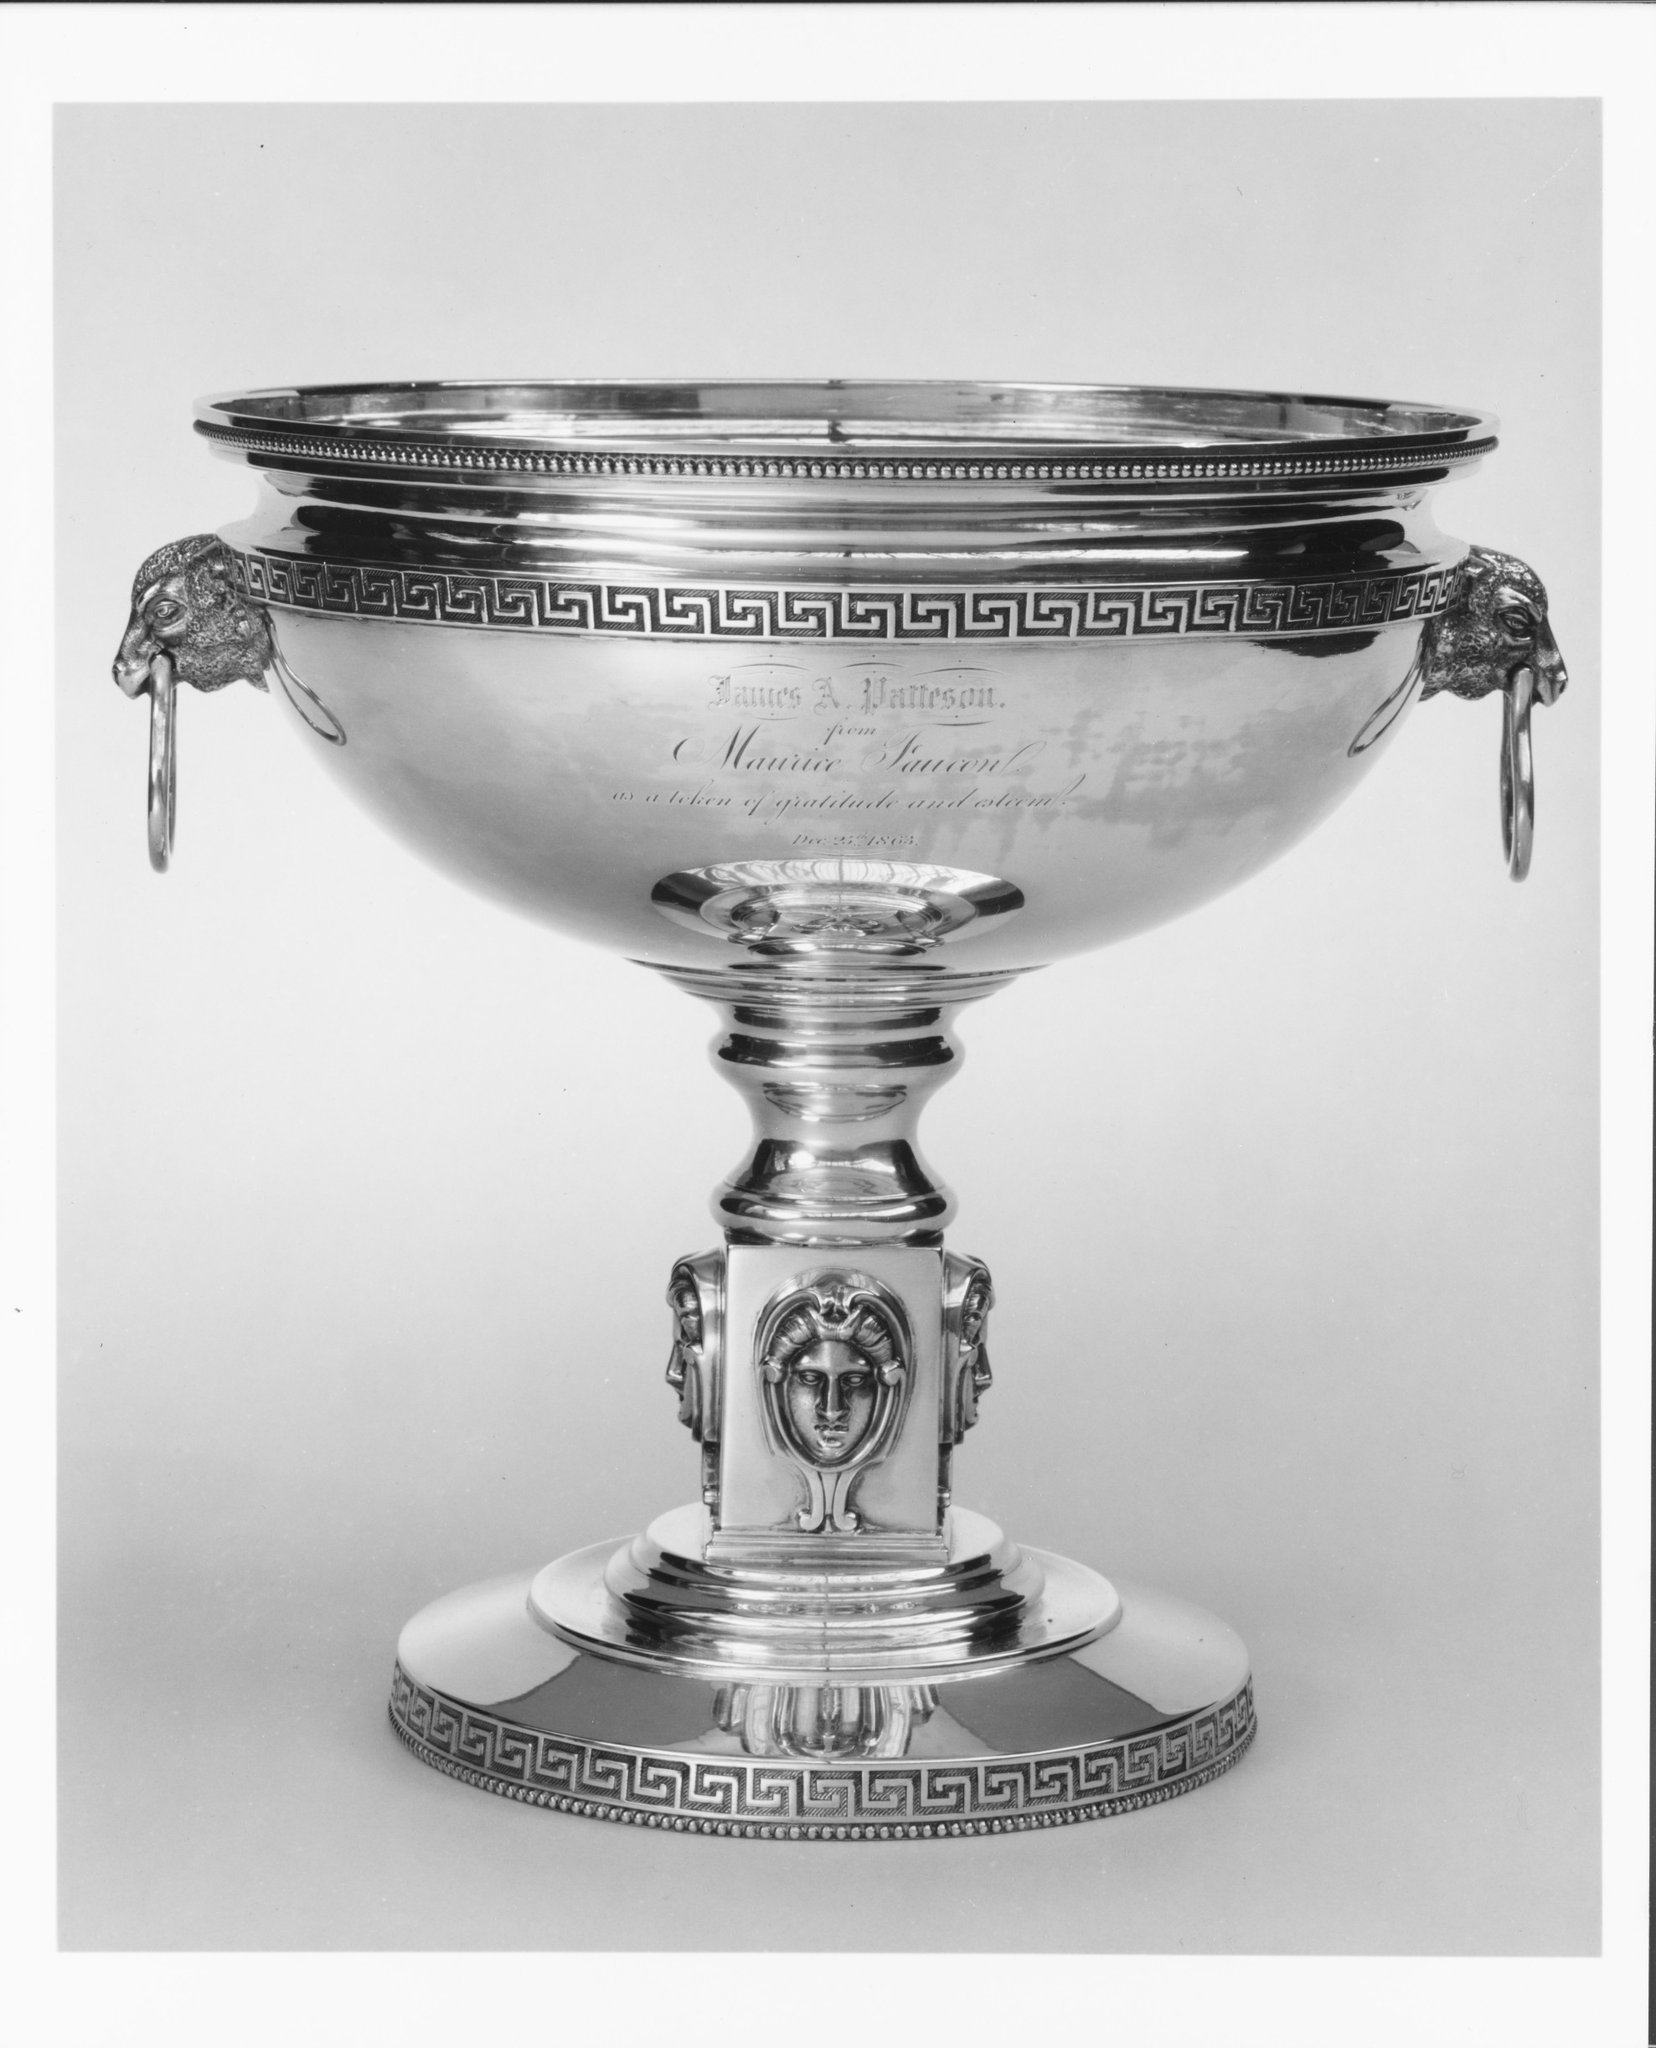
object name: compote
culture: american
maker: william gale and son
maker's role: maker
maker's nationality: american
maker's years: 1847-1866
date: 1860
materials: silver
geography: united states